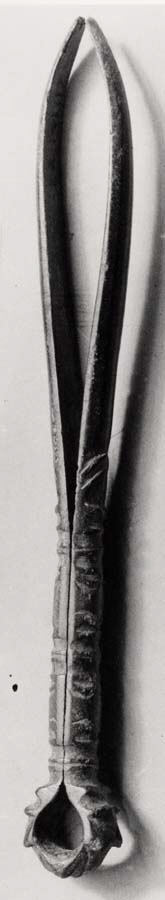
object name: tweezer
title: Tweezers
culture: korean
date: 918-1392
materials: bronze